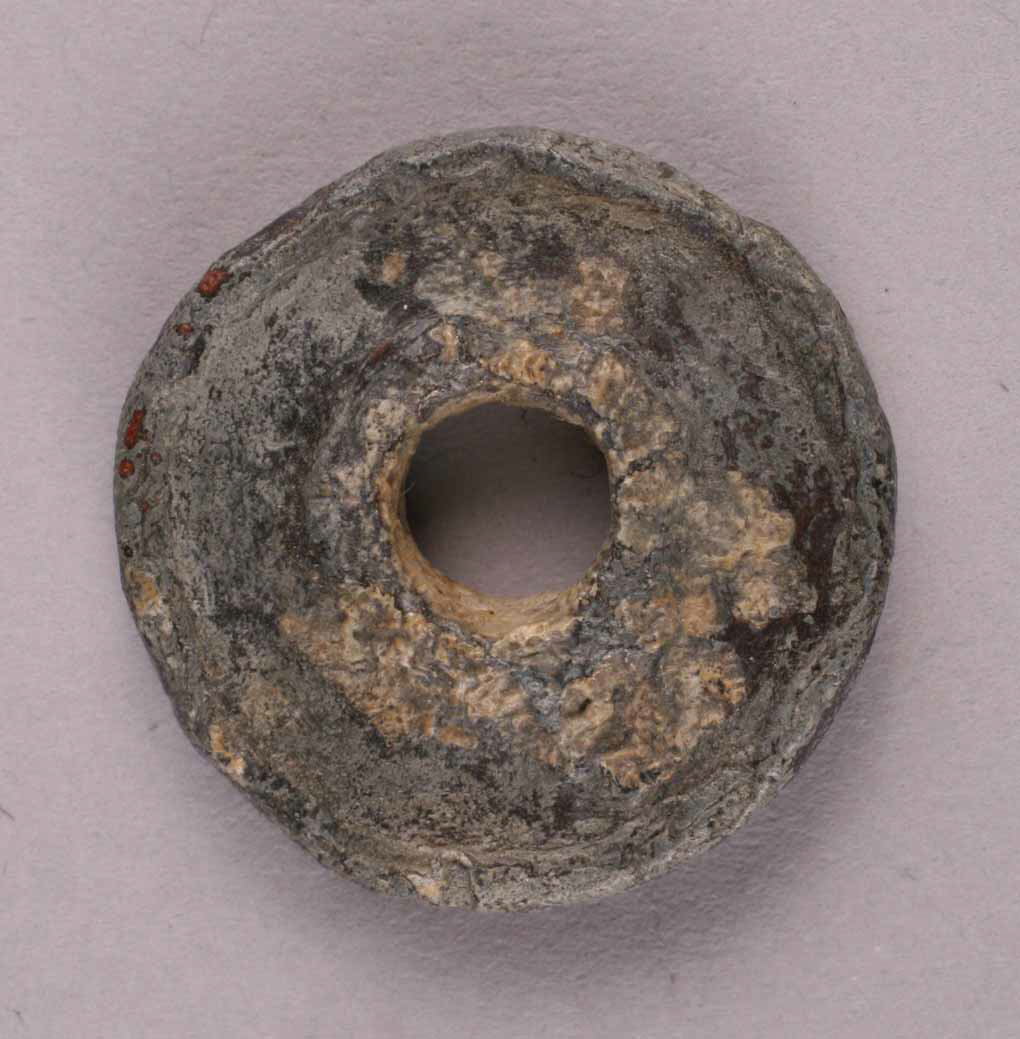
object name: weight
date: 801-1000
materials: lead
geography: iran